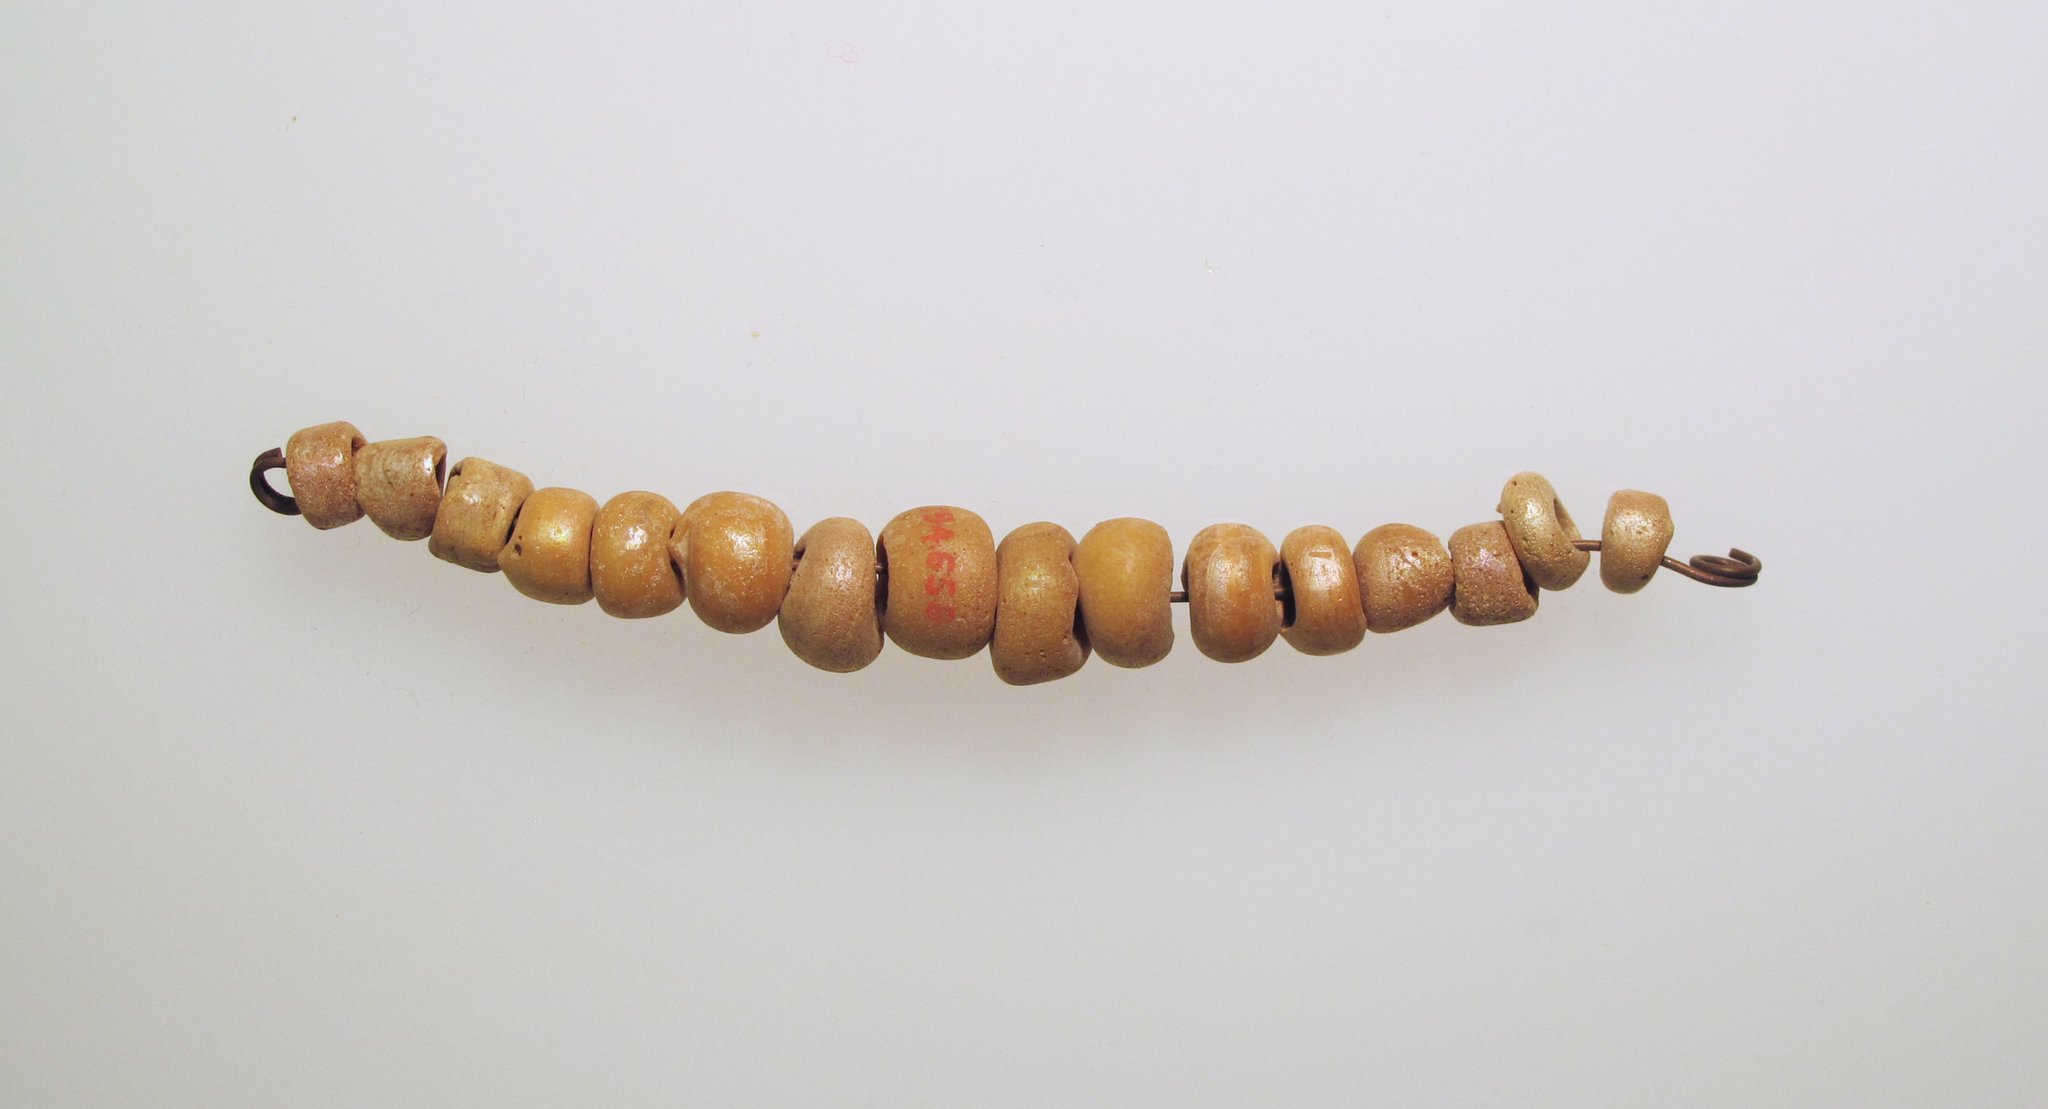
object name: bead, 16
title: Beads, 16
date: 7000 BCE-330 CE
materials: glass